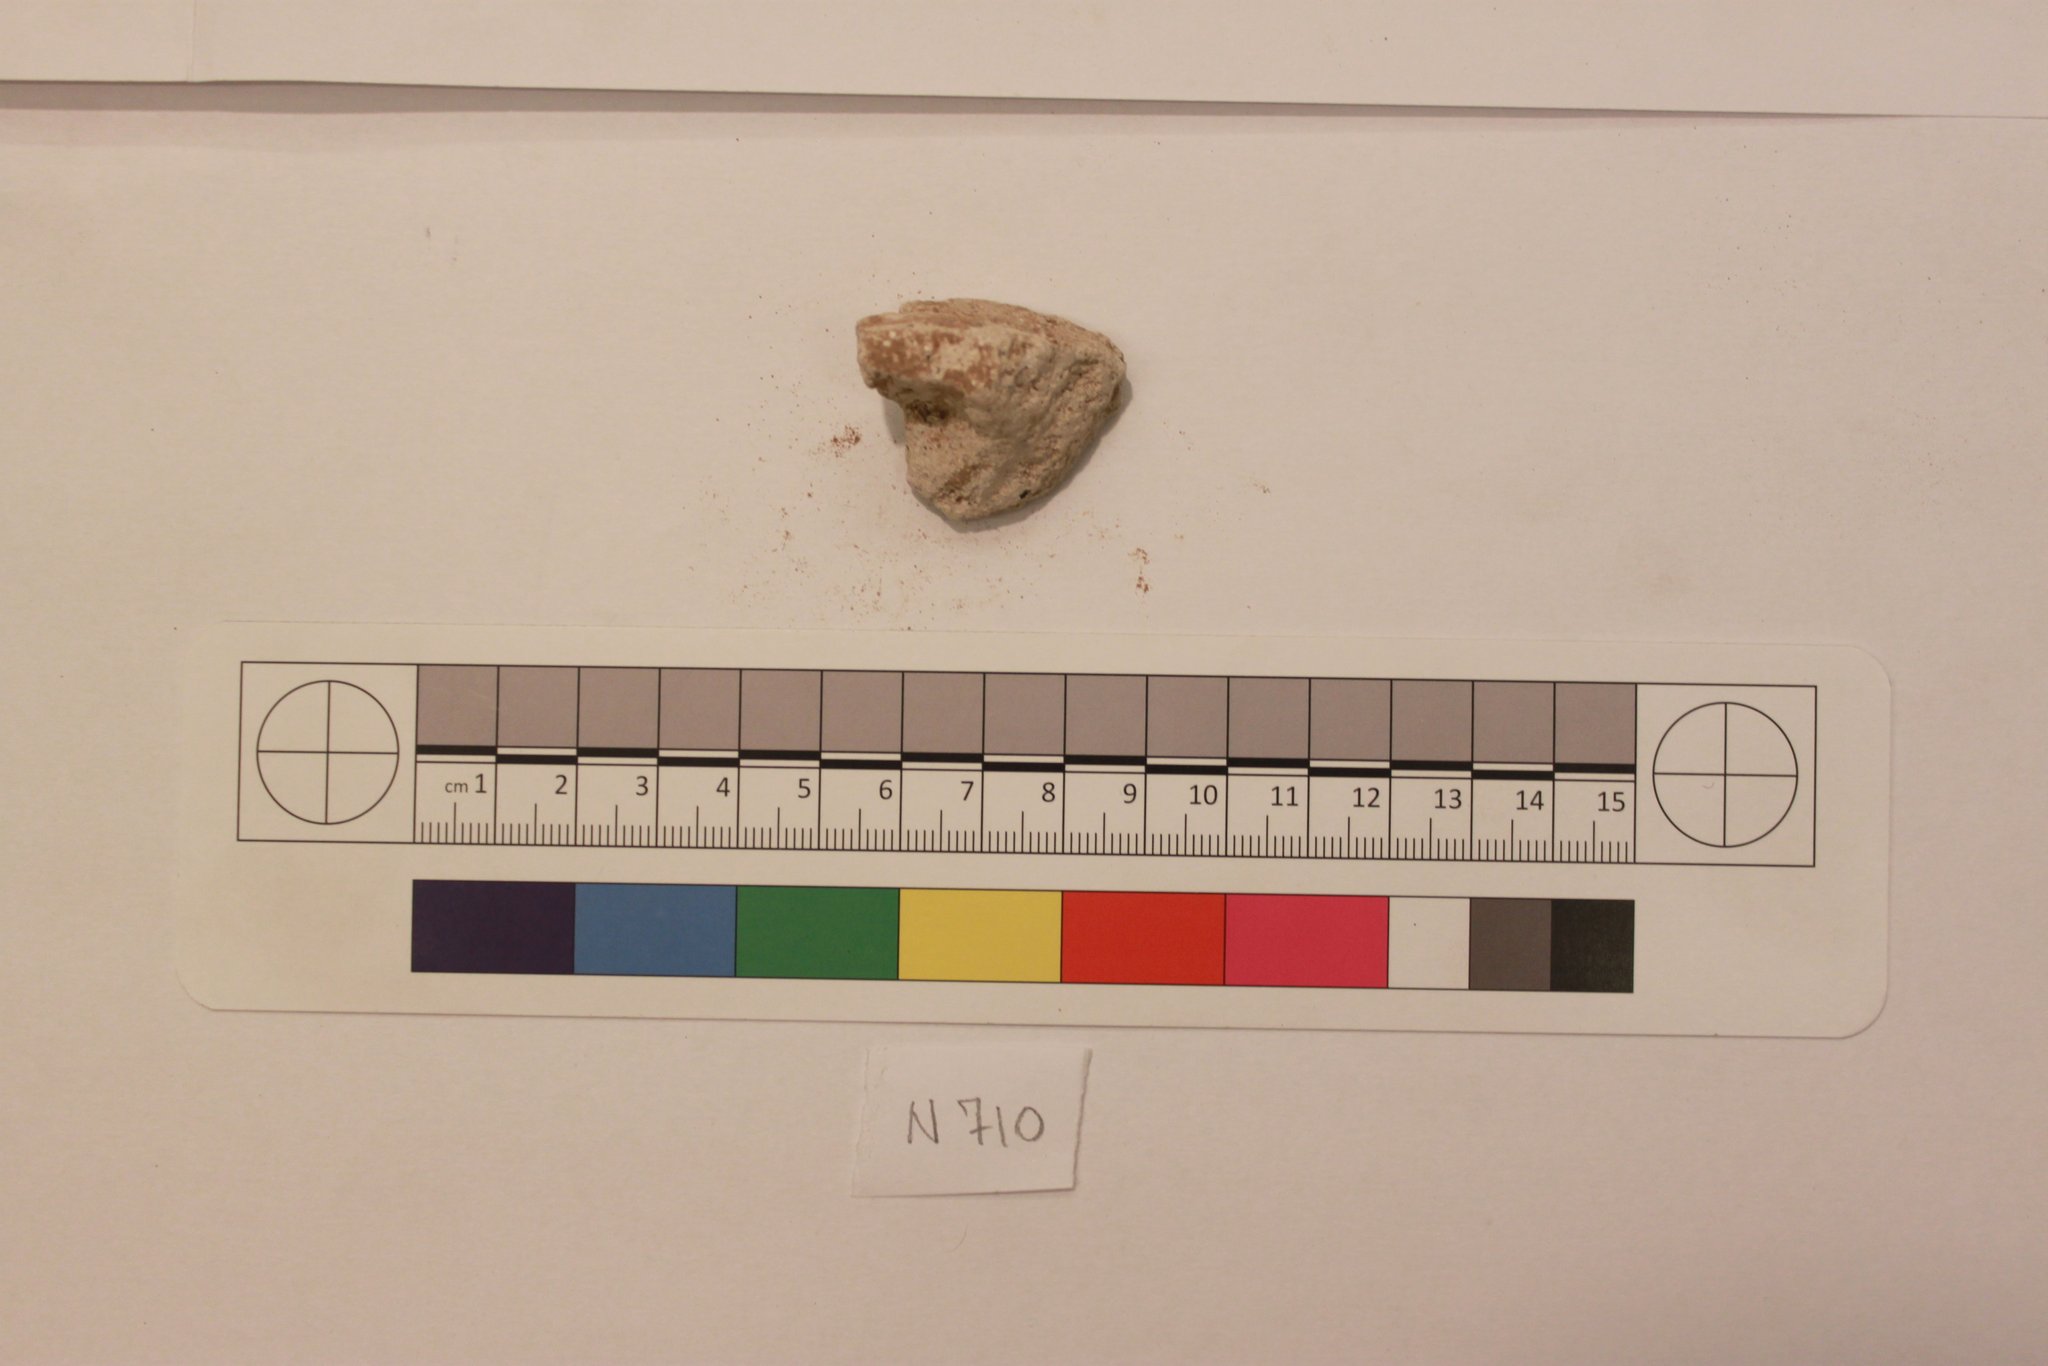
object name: fragment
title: Stucco Fragment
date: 701-1200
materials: plaster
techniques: carving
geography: iran